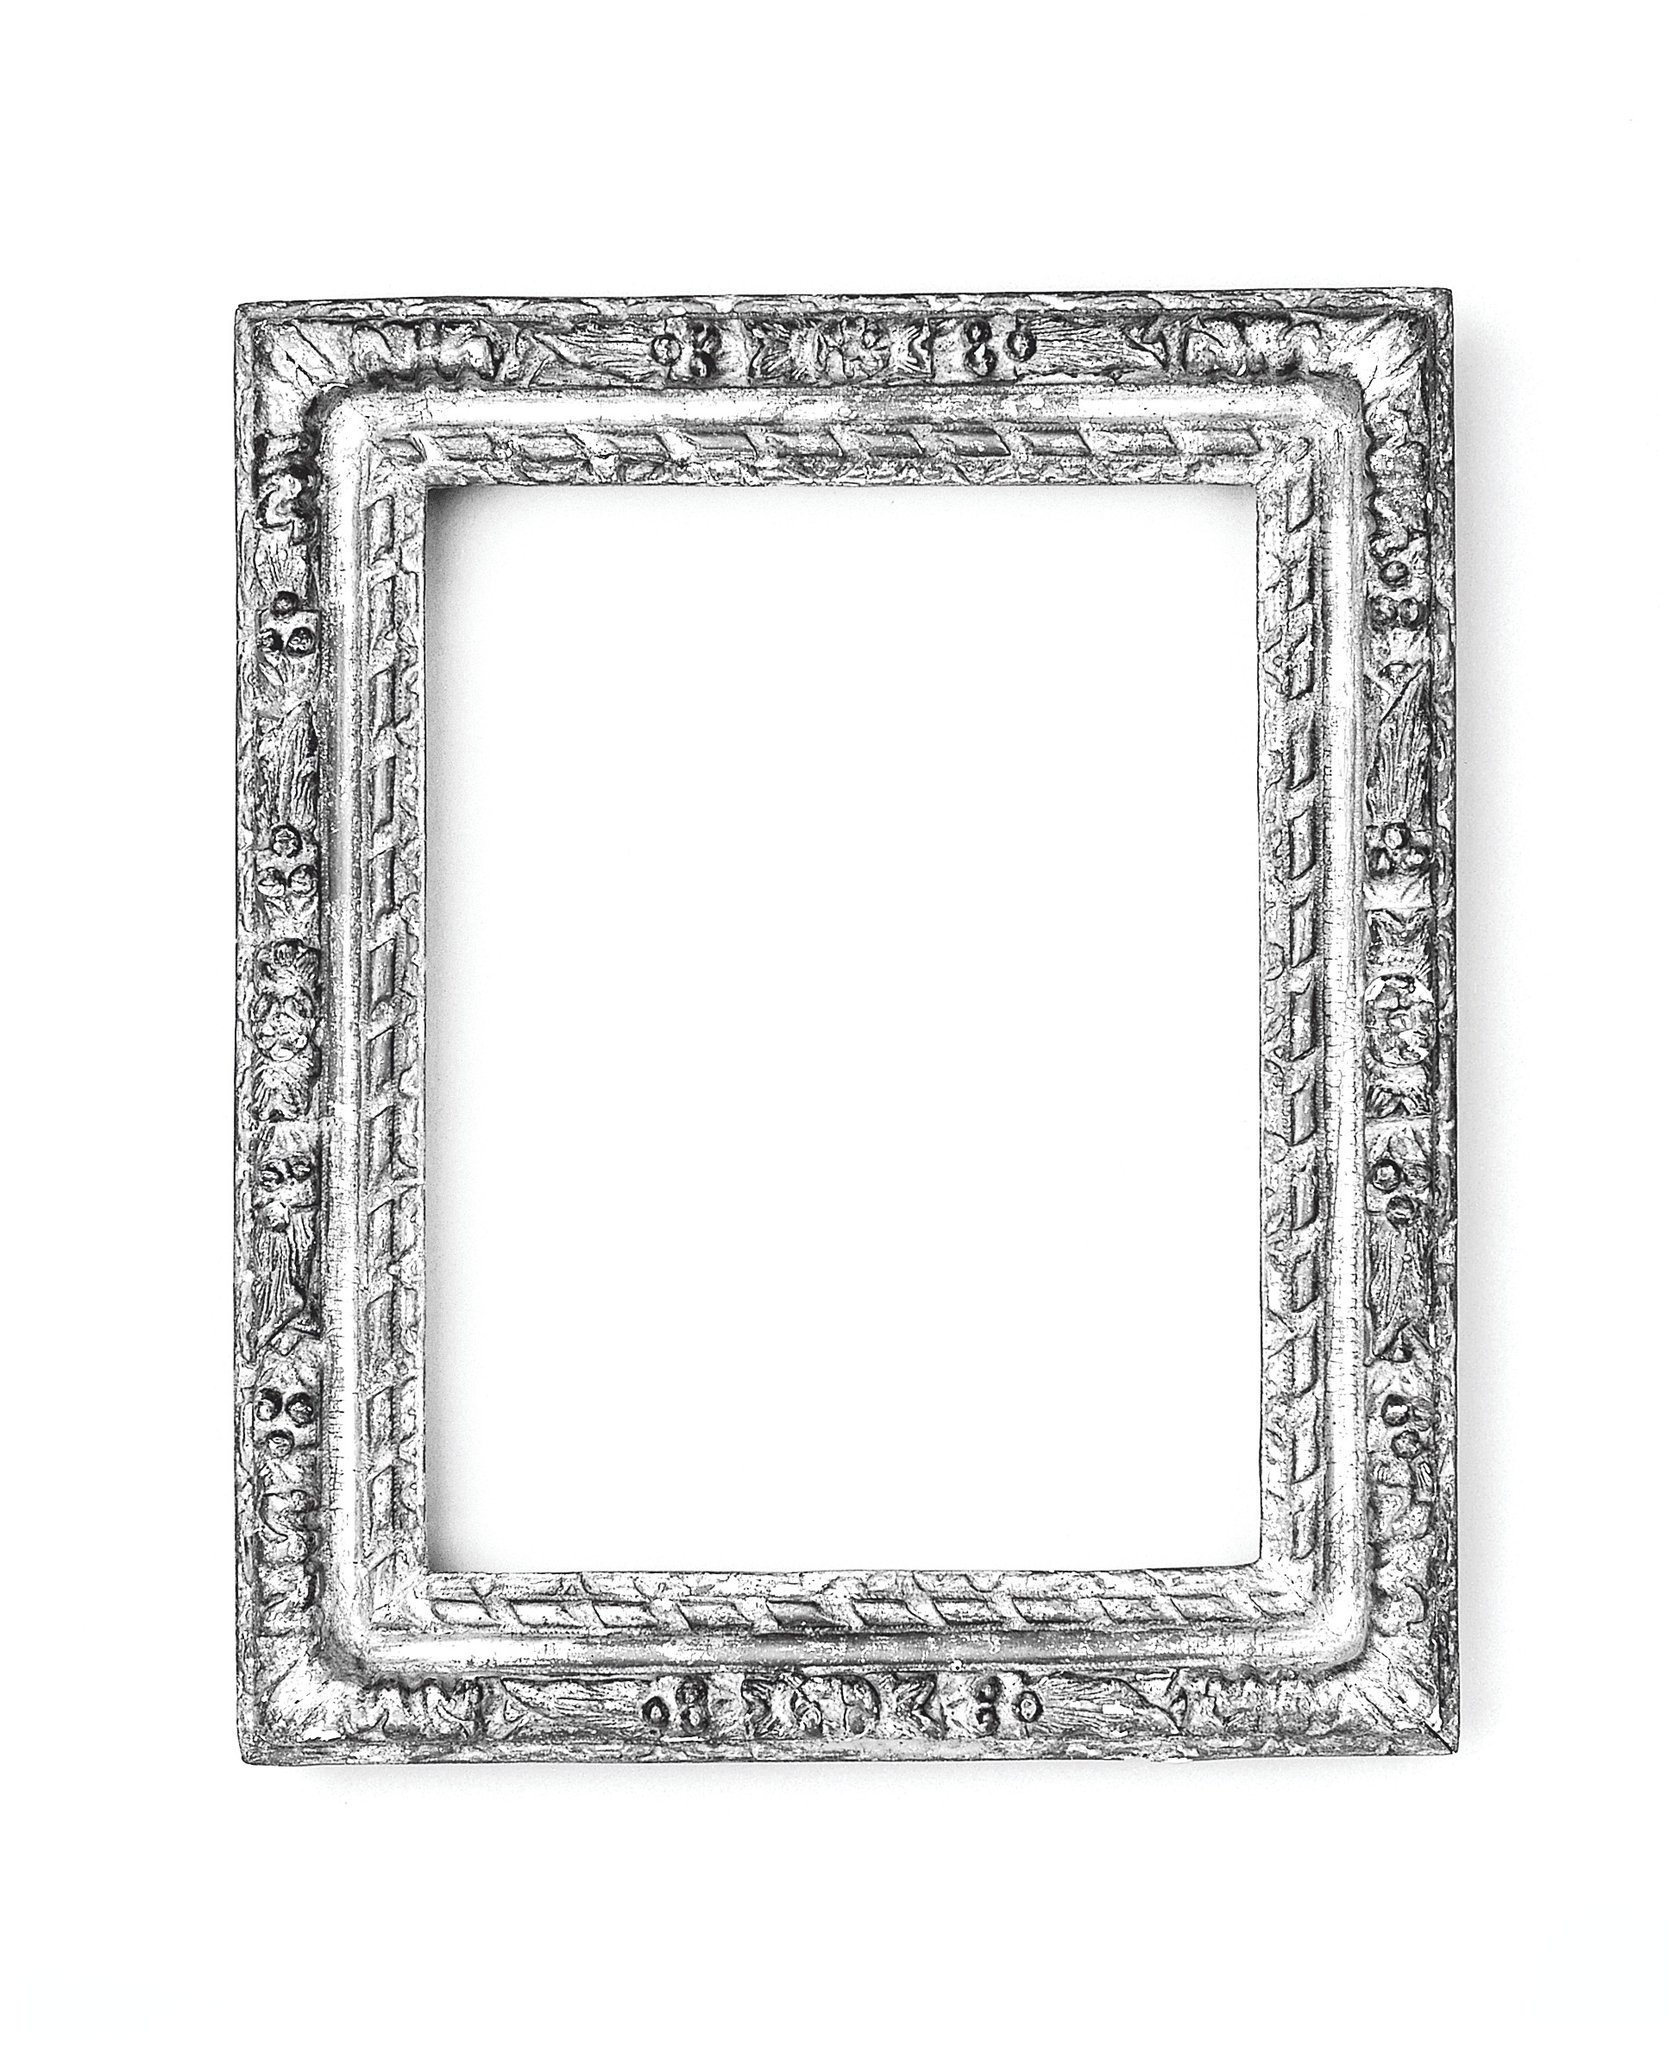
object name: frame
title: Astragal frame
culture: french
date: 1650-1660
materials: wood